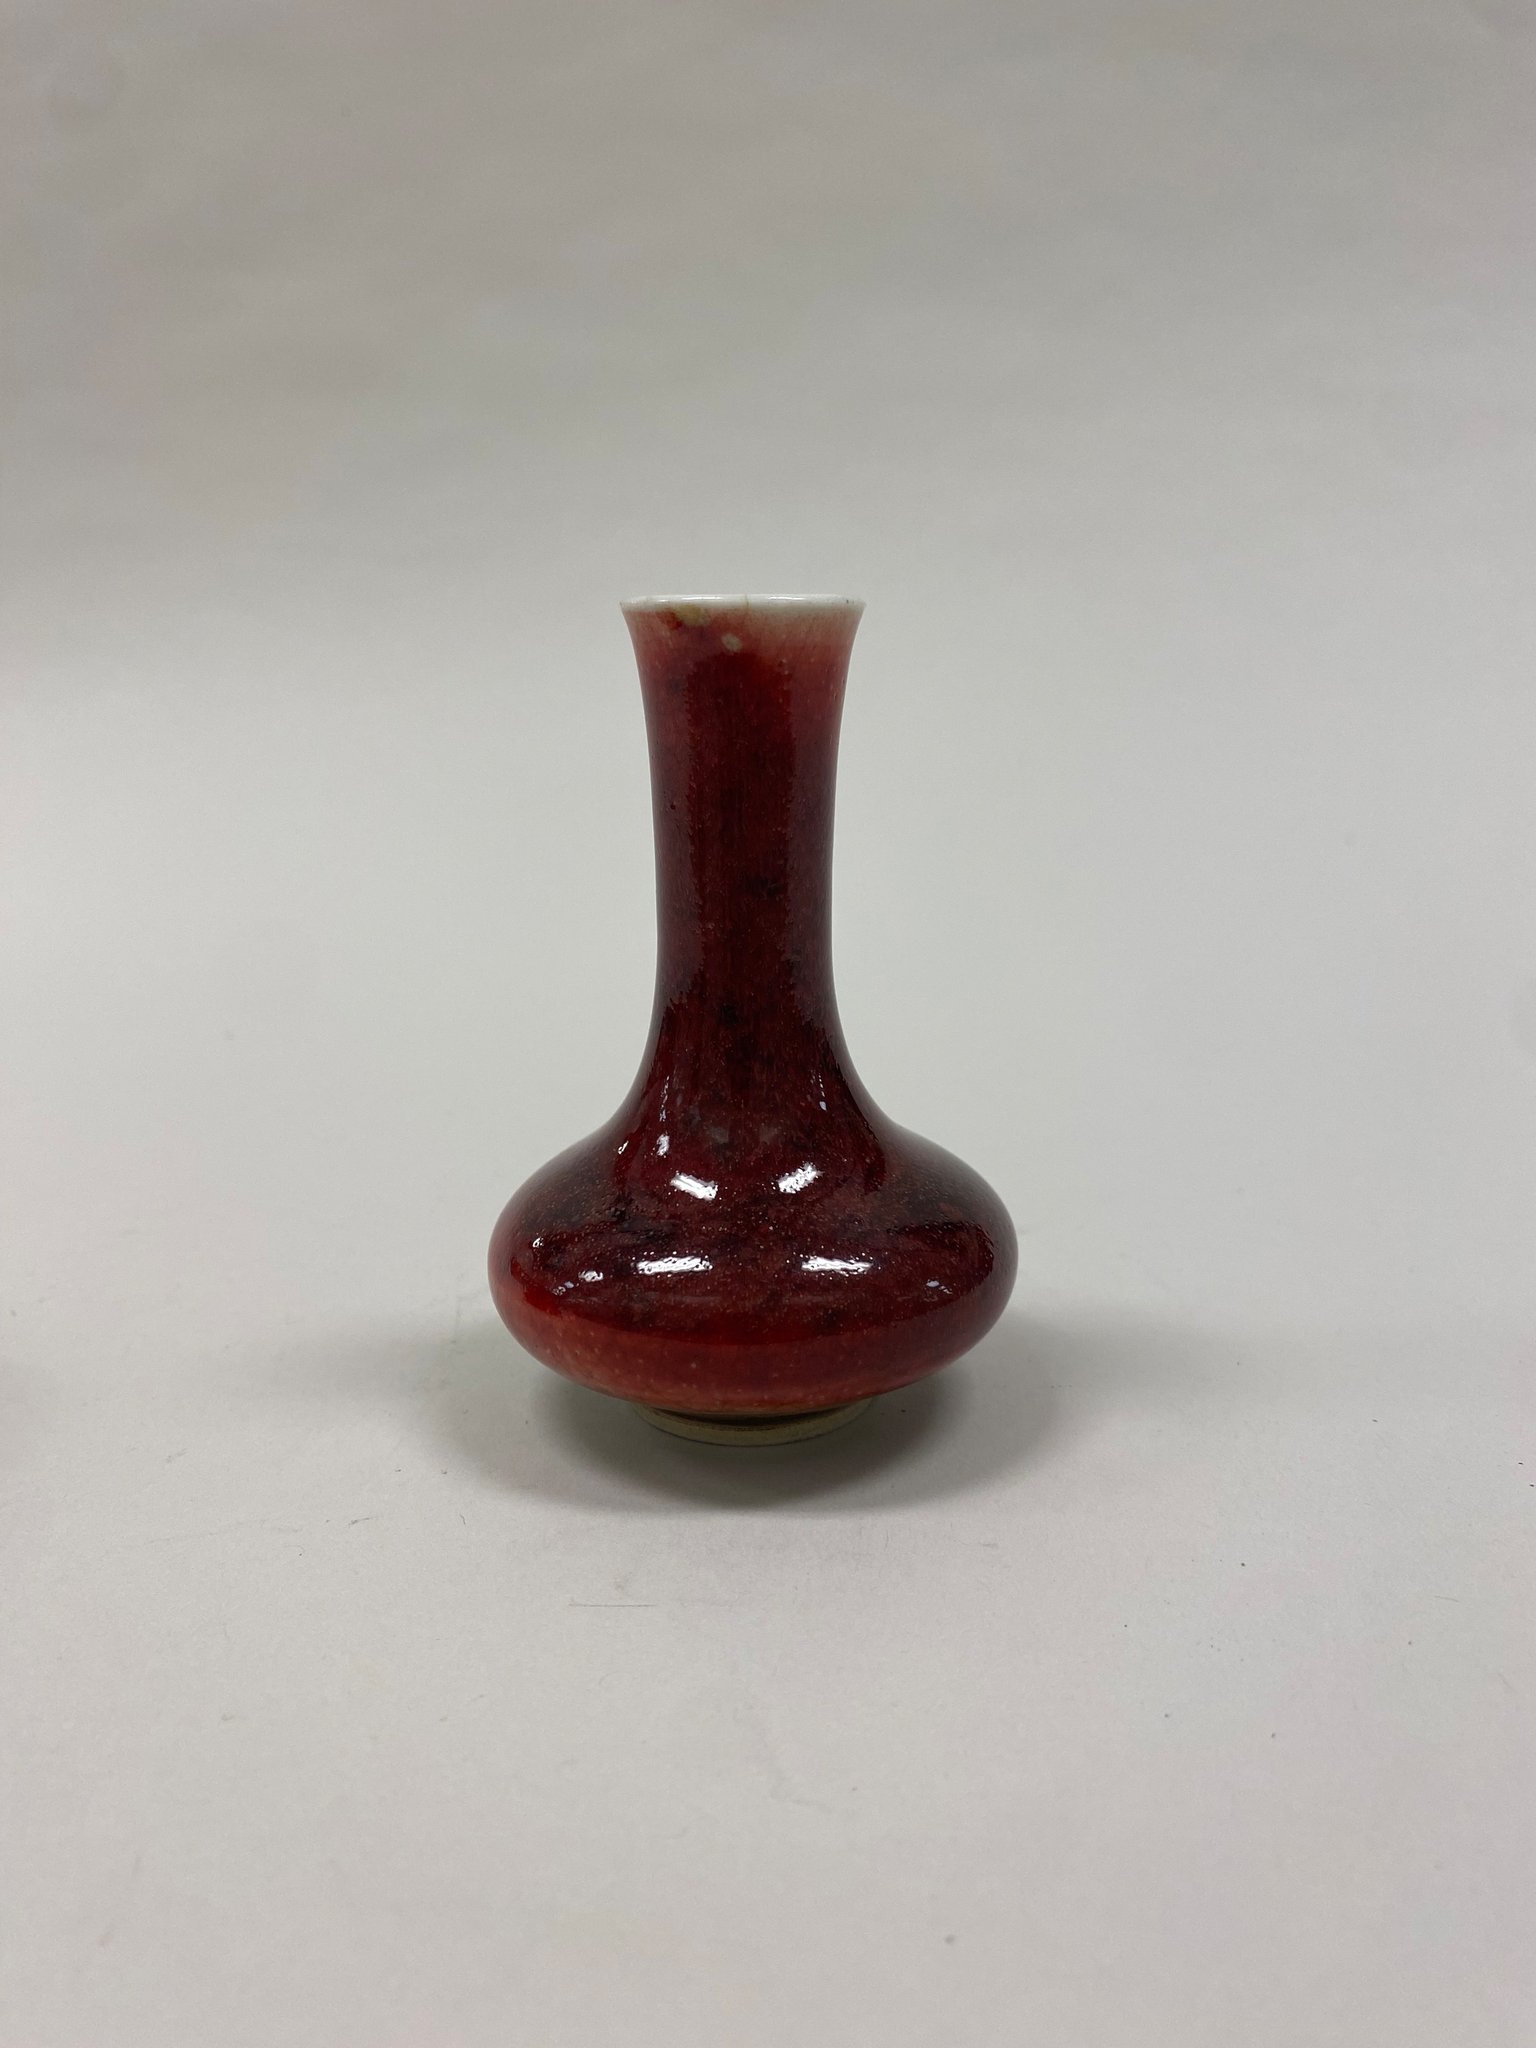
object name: vase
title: Minature vase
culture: chinese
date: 1701-1800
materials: copper, glaze, porcelain